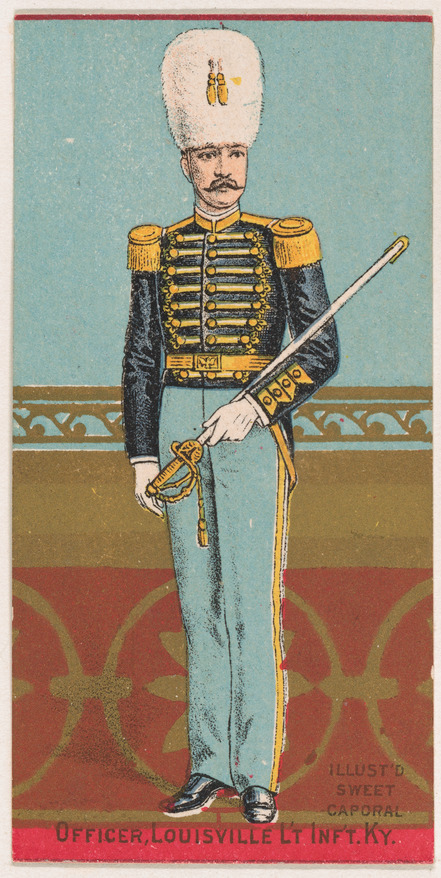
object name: print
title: Officer, Louisville, Light Infantry, Kentucky, from the Military Series (N224) issued by Kinney Tobacco Company to promote Sweet Caporal Cigarettes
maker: kinney brothers tobacco company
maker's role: publisher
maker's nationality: american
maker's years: 1869-2011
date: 1888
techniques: color lithograph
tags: military,men